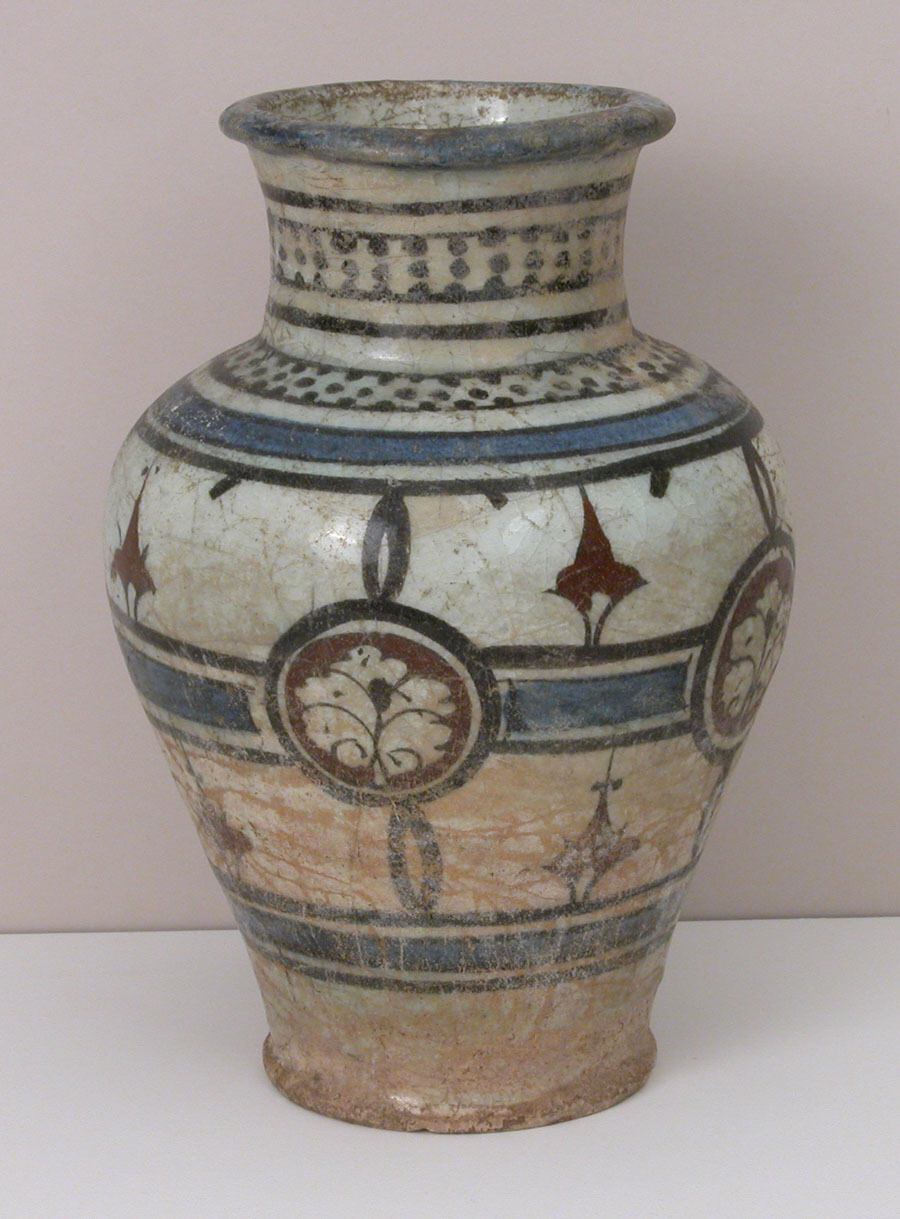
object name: jar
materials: glaze, stonepaste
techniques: painting, polychrome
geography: syria